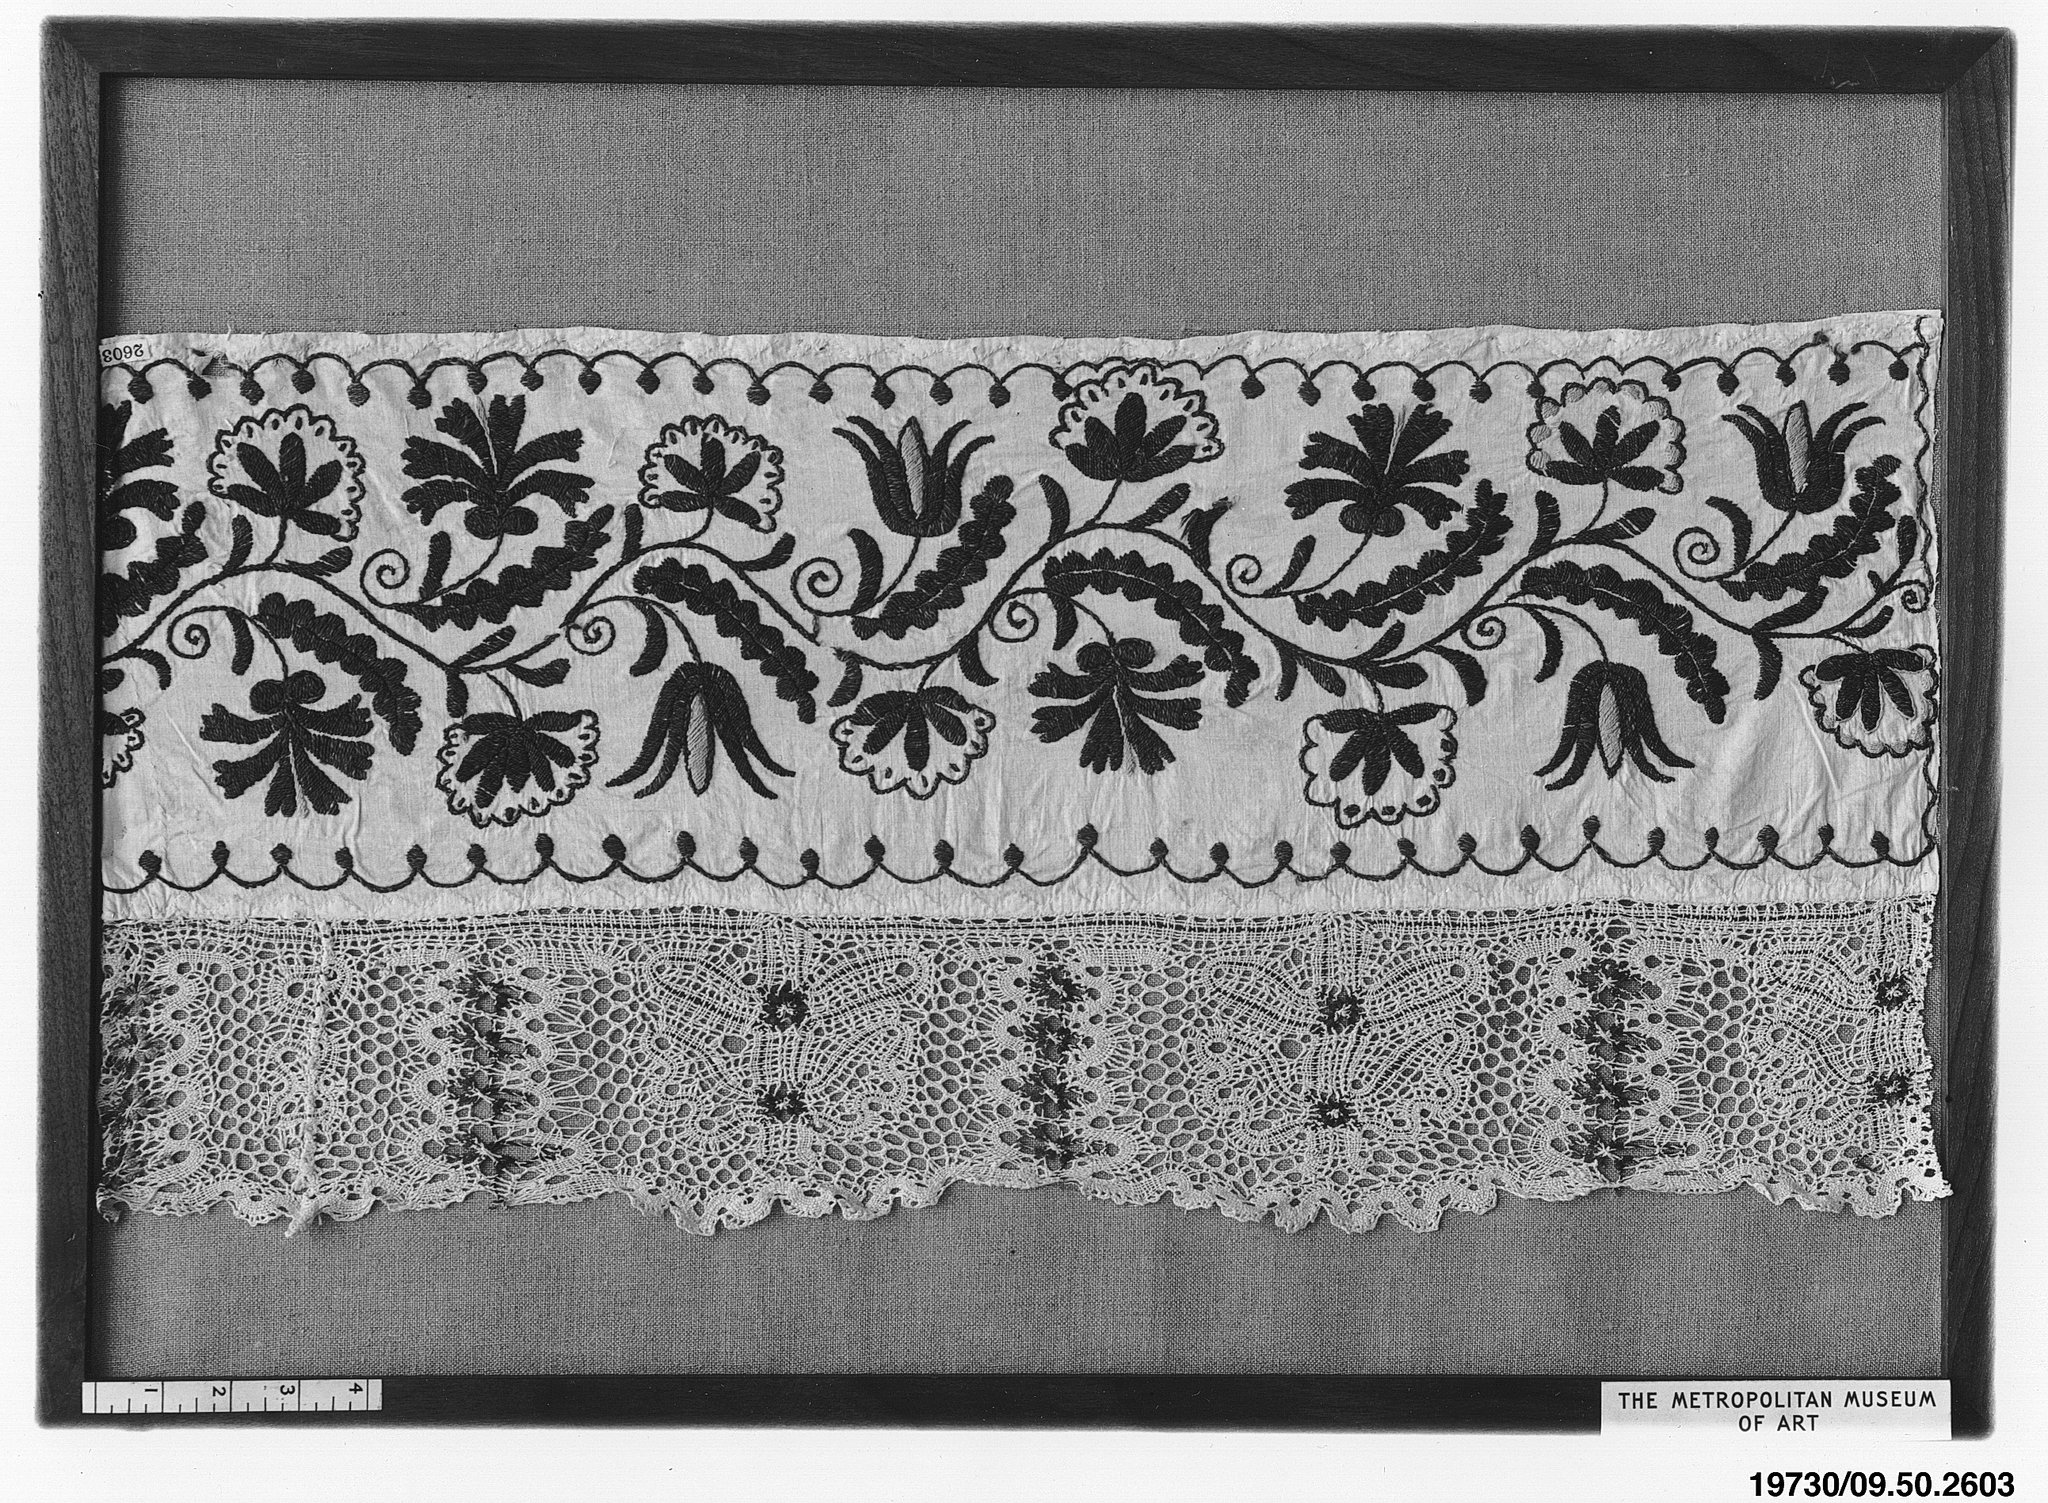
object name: border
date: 1801-1825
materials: cotton, linen